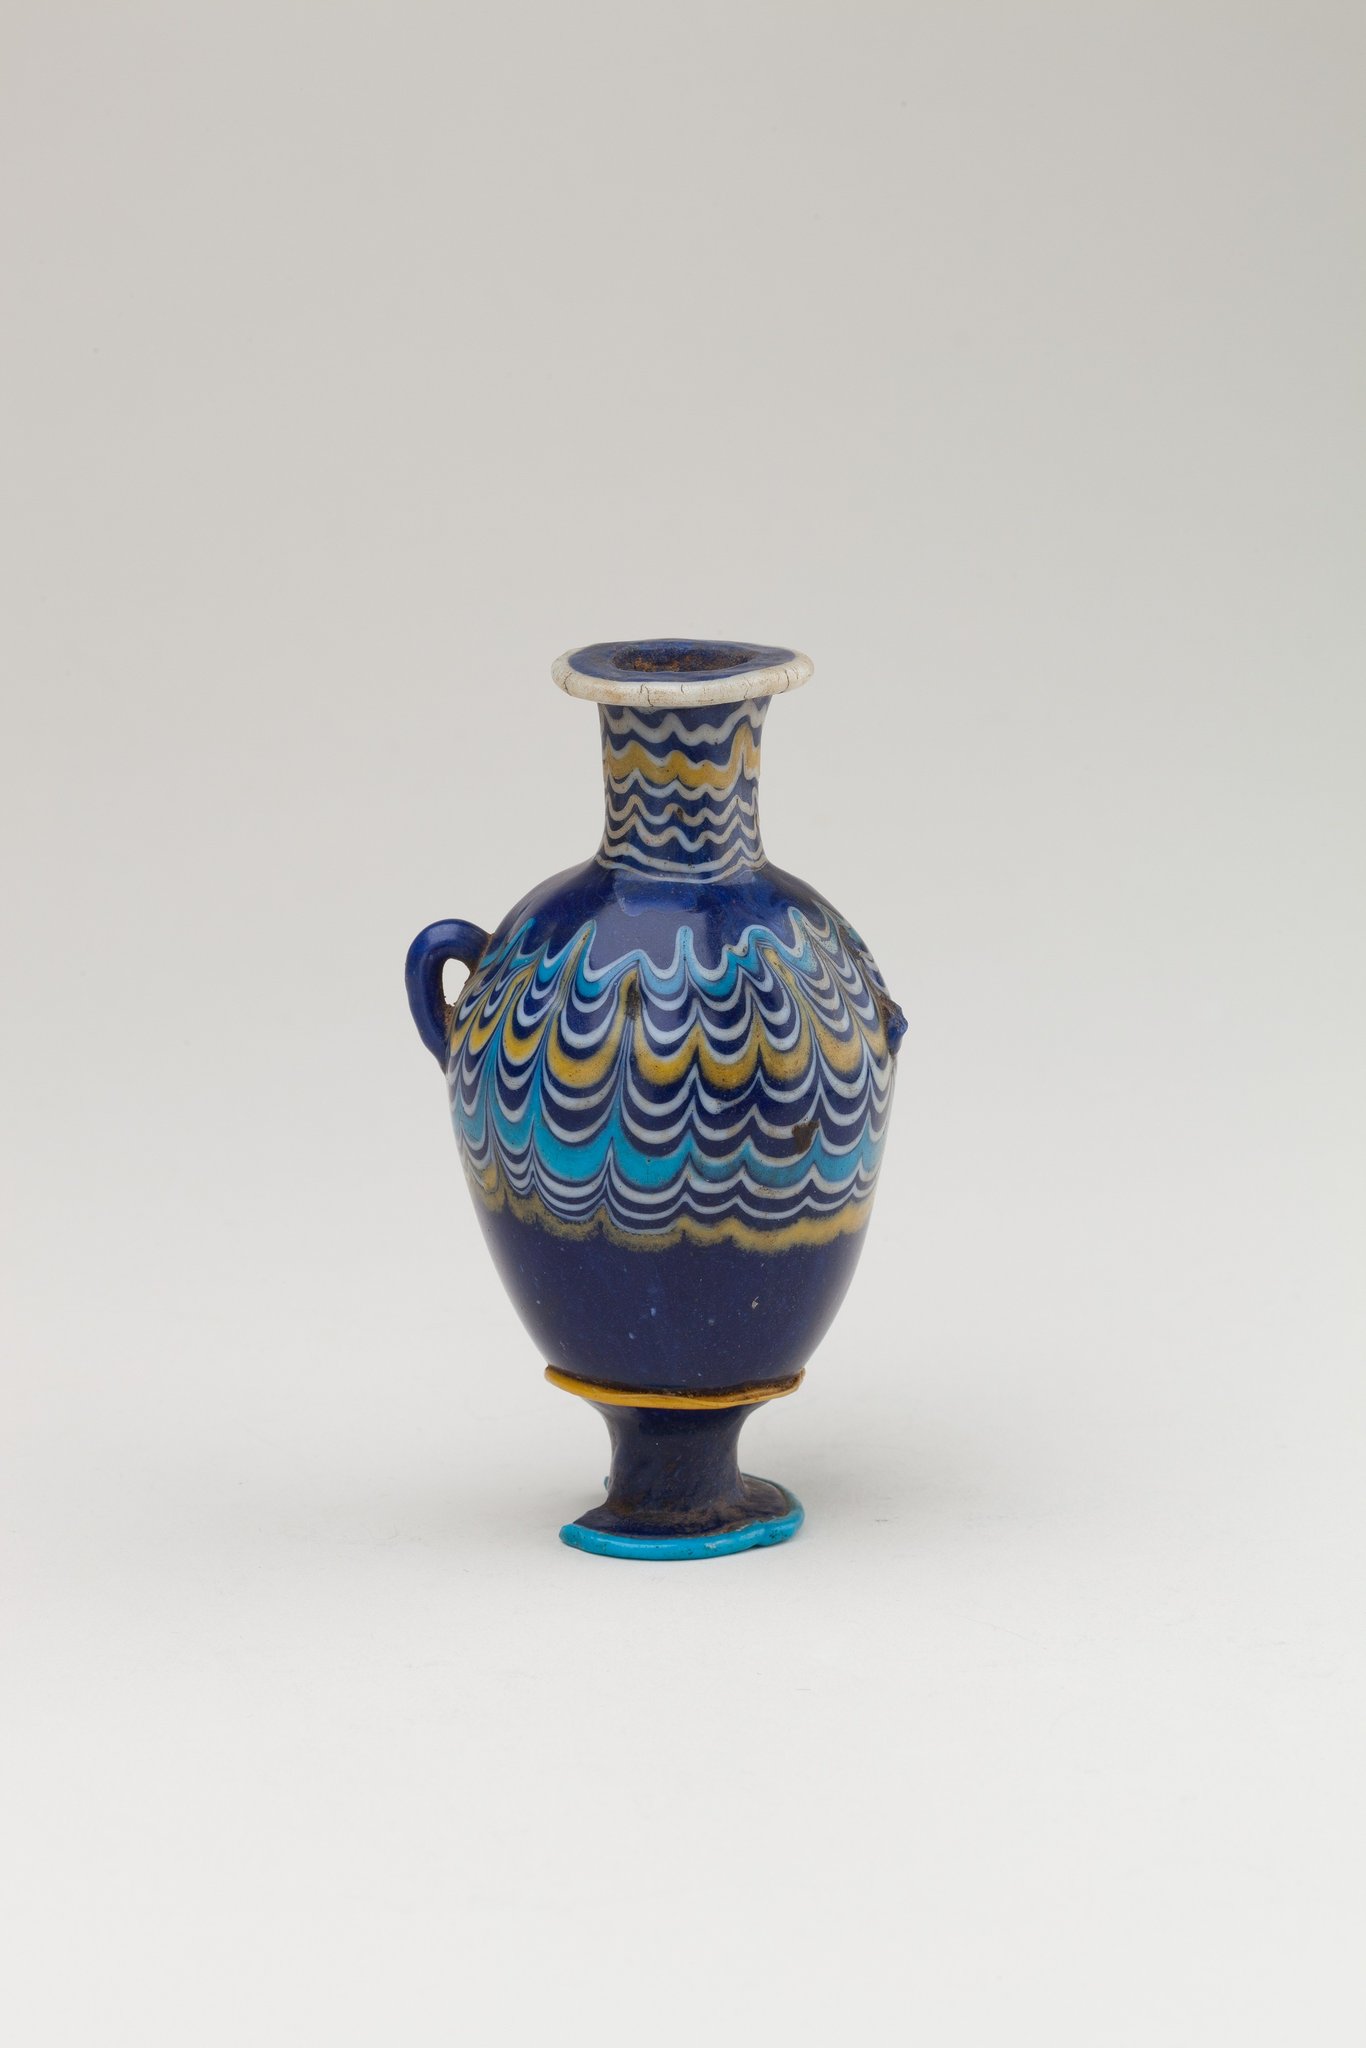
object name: vase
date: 1550-1295 BCE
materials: glass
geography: egypt